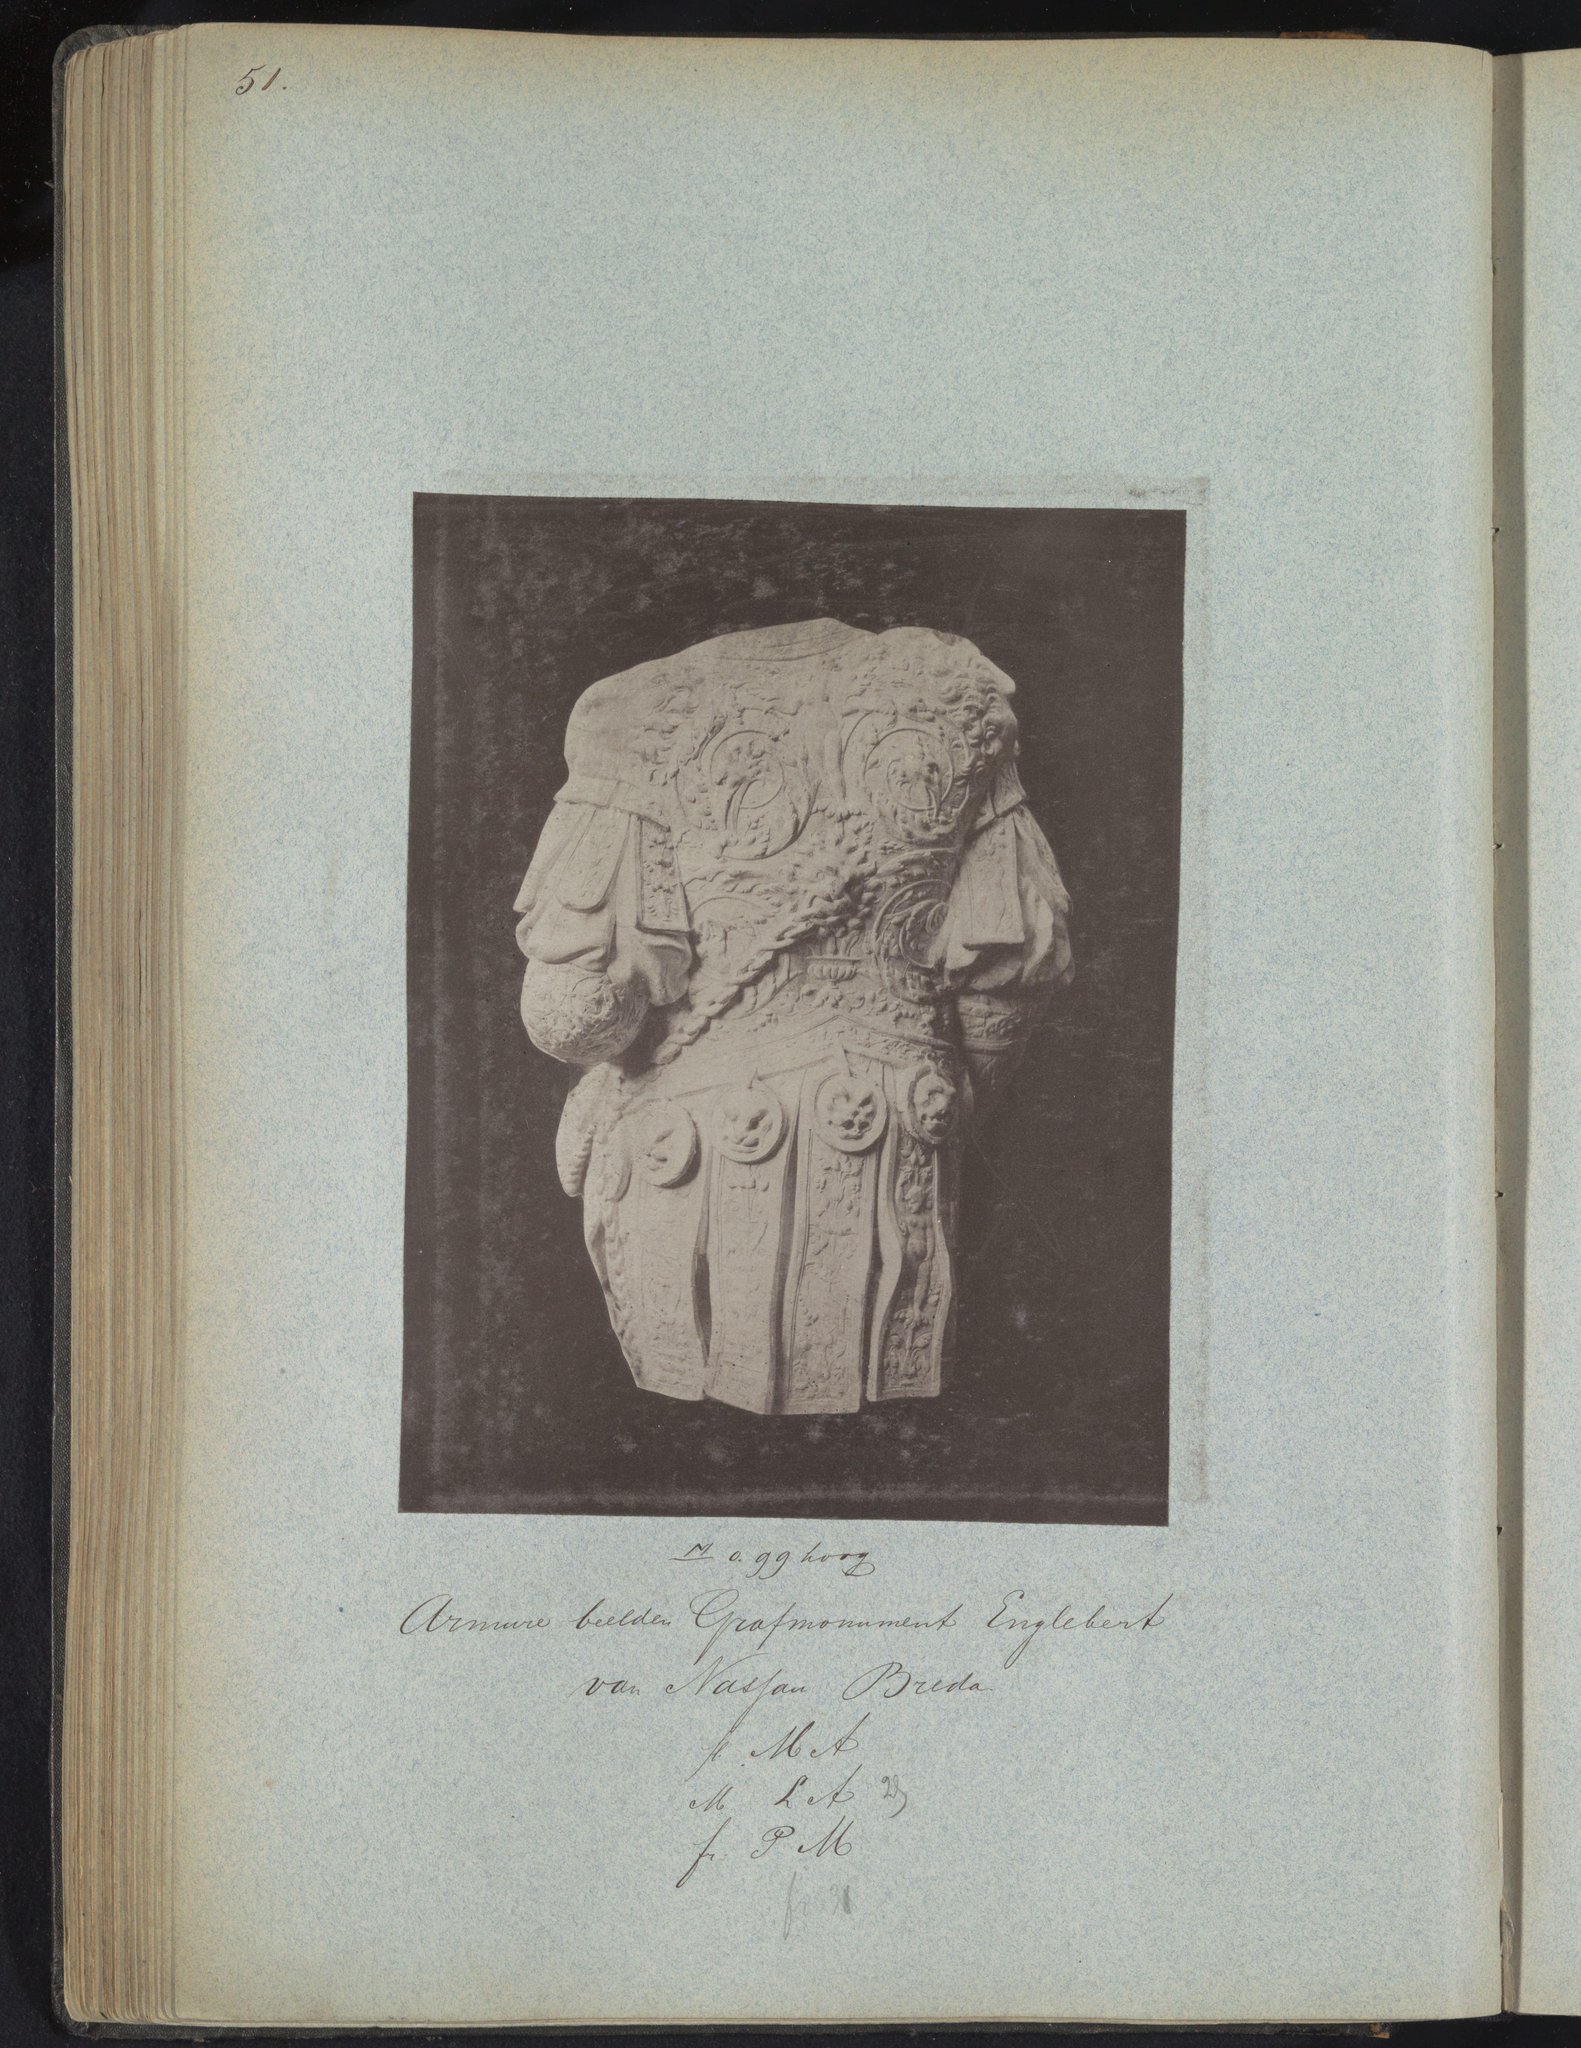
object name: album leaf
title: Gipsen afgietsel van een harnas van het grafmonument van Engelbrecht II, graaf van van Nassau, uit de Prinsenkapel van de Onze-Lieve-Vrouwekerk te Breda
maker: Anonymous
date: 1875-1900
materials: paper, photographic support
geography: breda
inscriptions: annotation: ‘Armure beelden Grafmonument Englebrecht / van Nassau Breda’, annotation, annotation: ‘M 0.99 hoog’